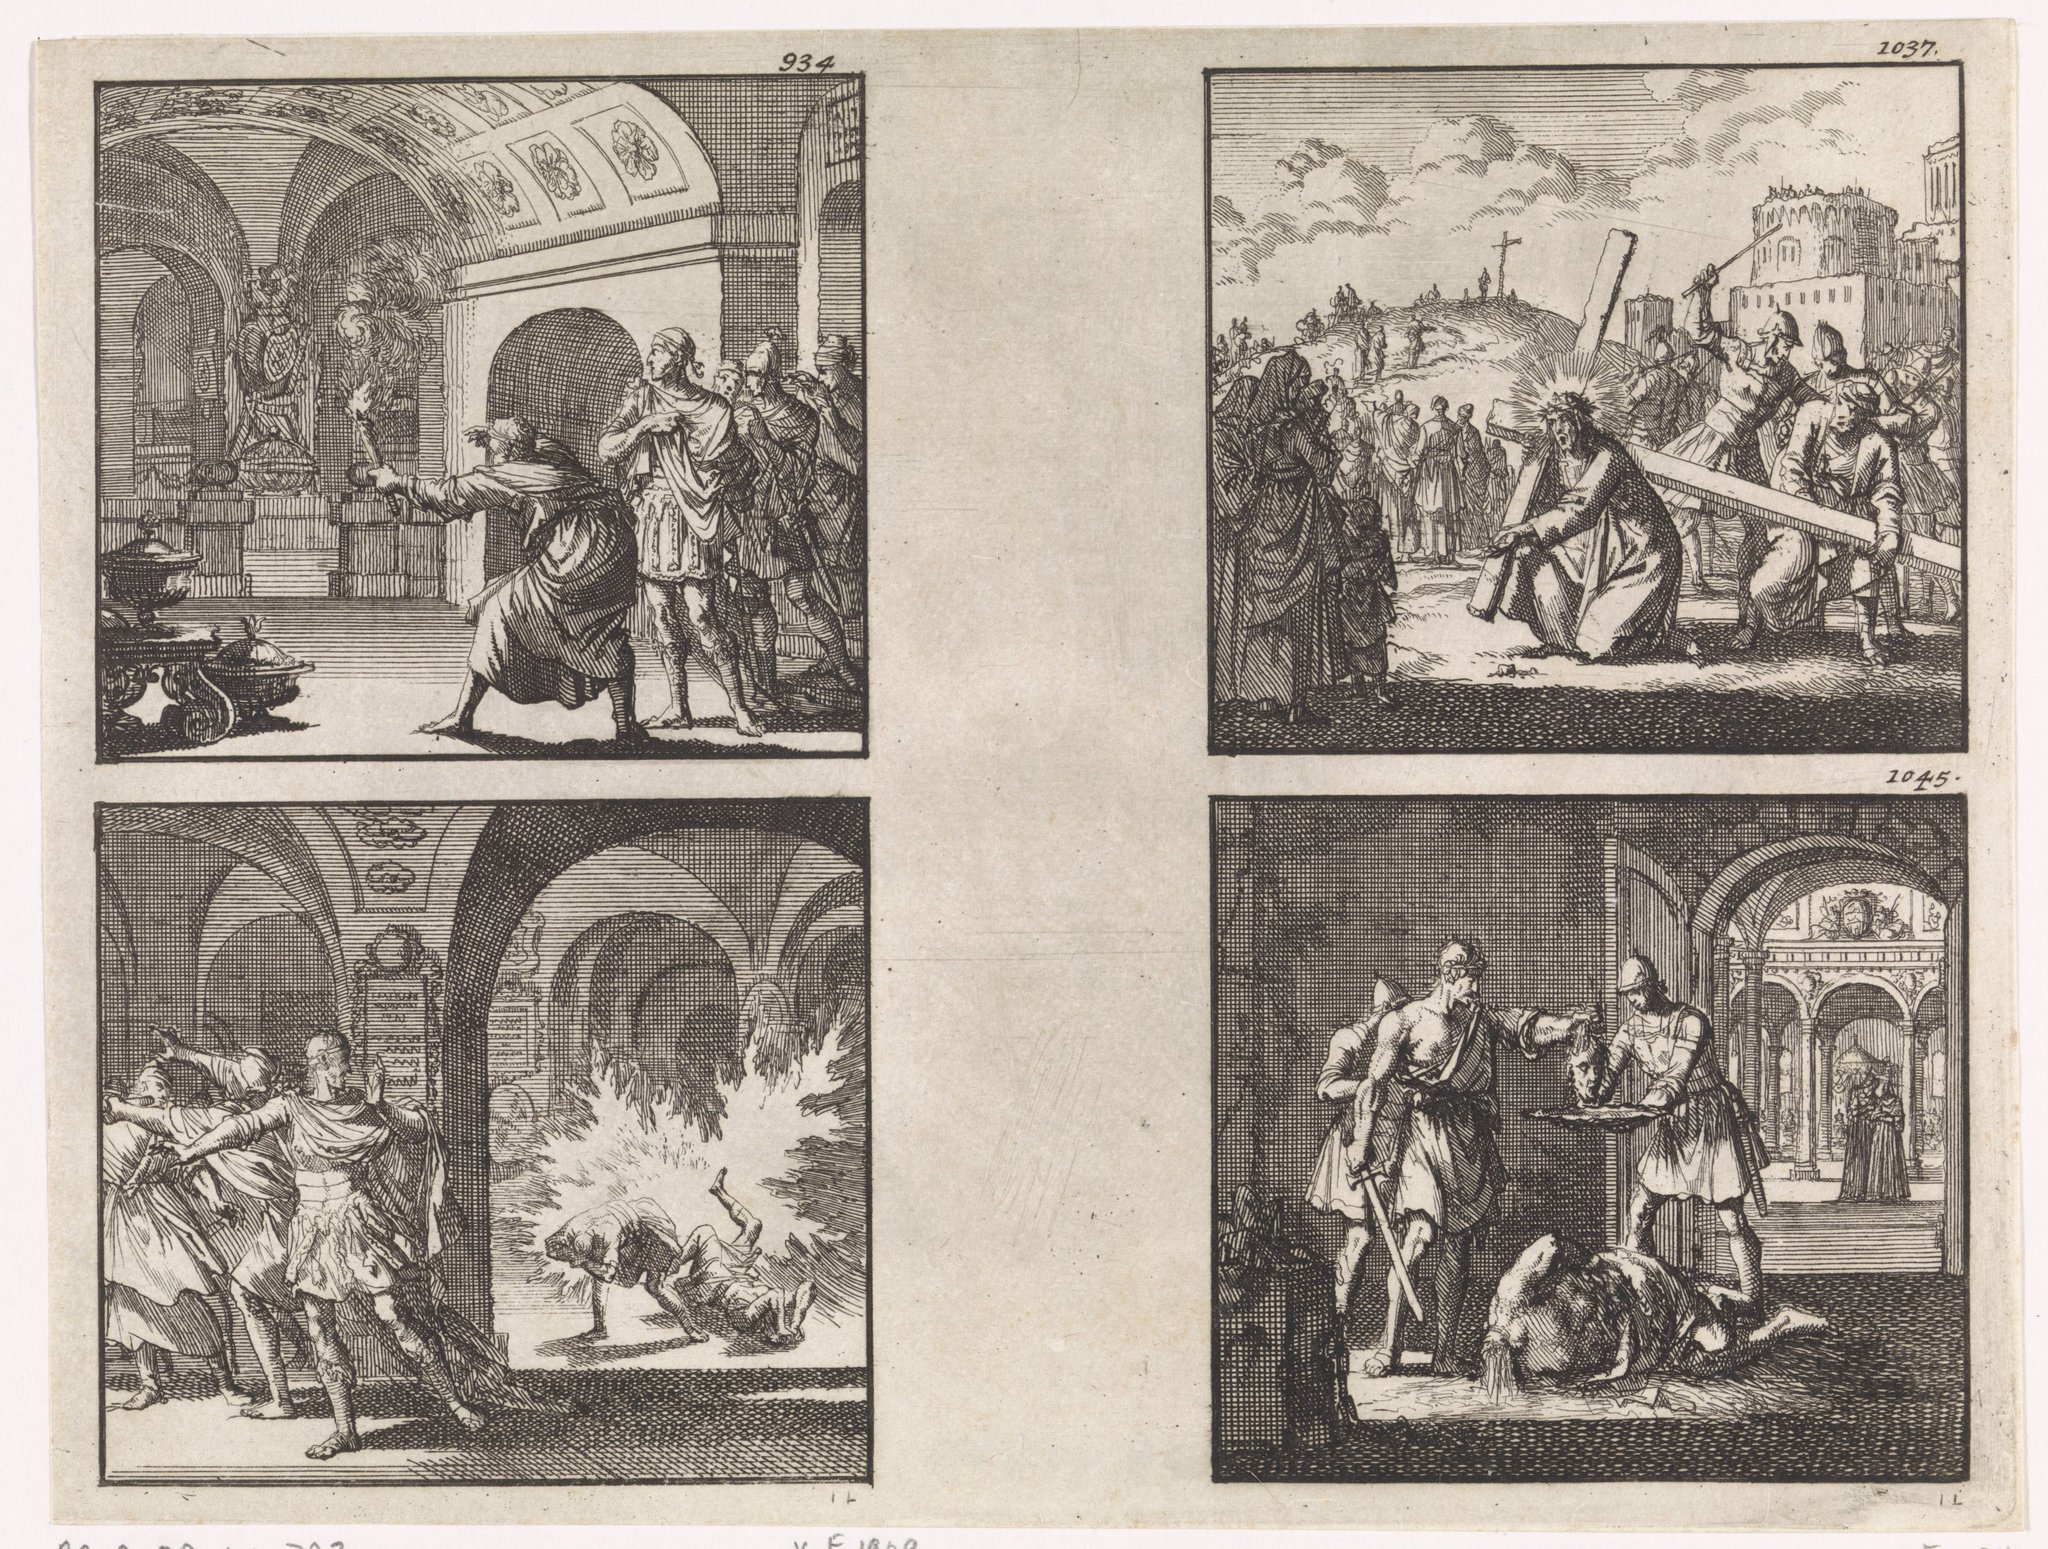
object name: book illustration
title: Herodes in David's graf / Herodes' soldaten worden in het graf van David door een vlam gedood / De kruisdraging / Onthoofding van Johannes de Doper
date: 1698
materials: paper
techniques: etching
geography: amsterdam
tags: prison, jail, david's grave, plundering of david's grave by herod the great, carrying of the cross: christ bearing the cross, alone or with the help of others (e.g. simon the cyrenian)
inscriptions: collector's mark: Lugt 2228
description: Illustraties uit: Josephus, Flavius. XX. boeken van de oude geschiedenissen der joden, 4 delen. Amsterdam: Barent Visscher, Willem de Coup, Willem van Lamsveld, Andries van Damme, 1698, dl. II.